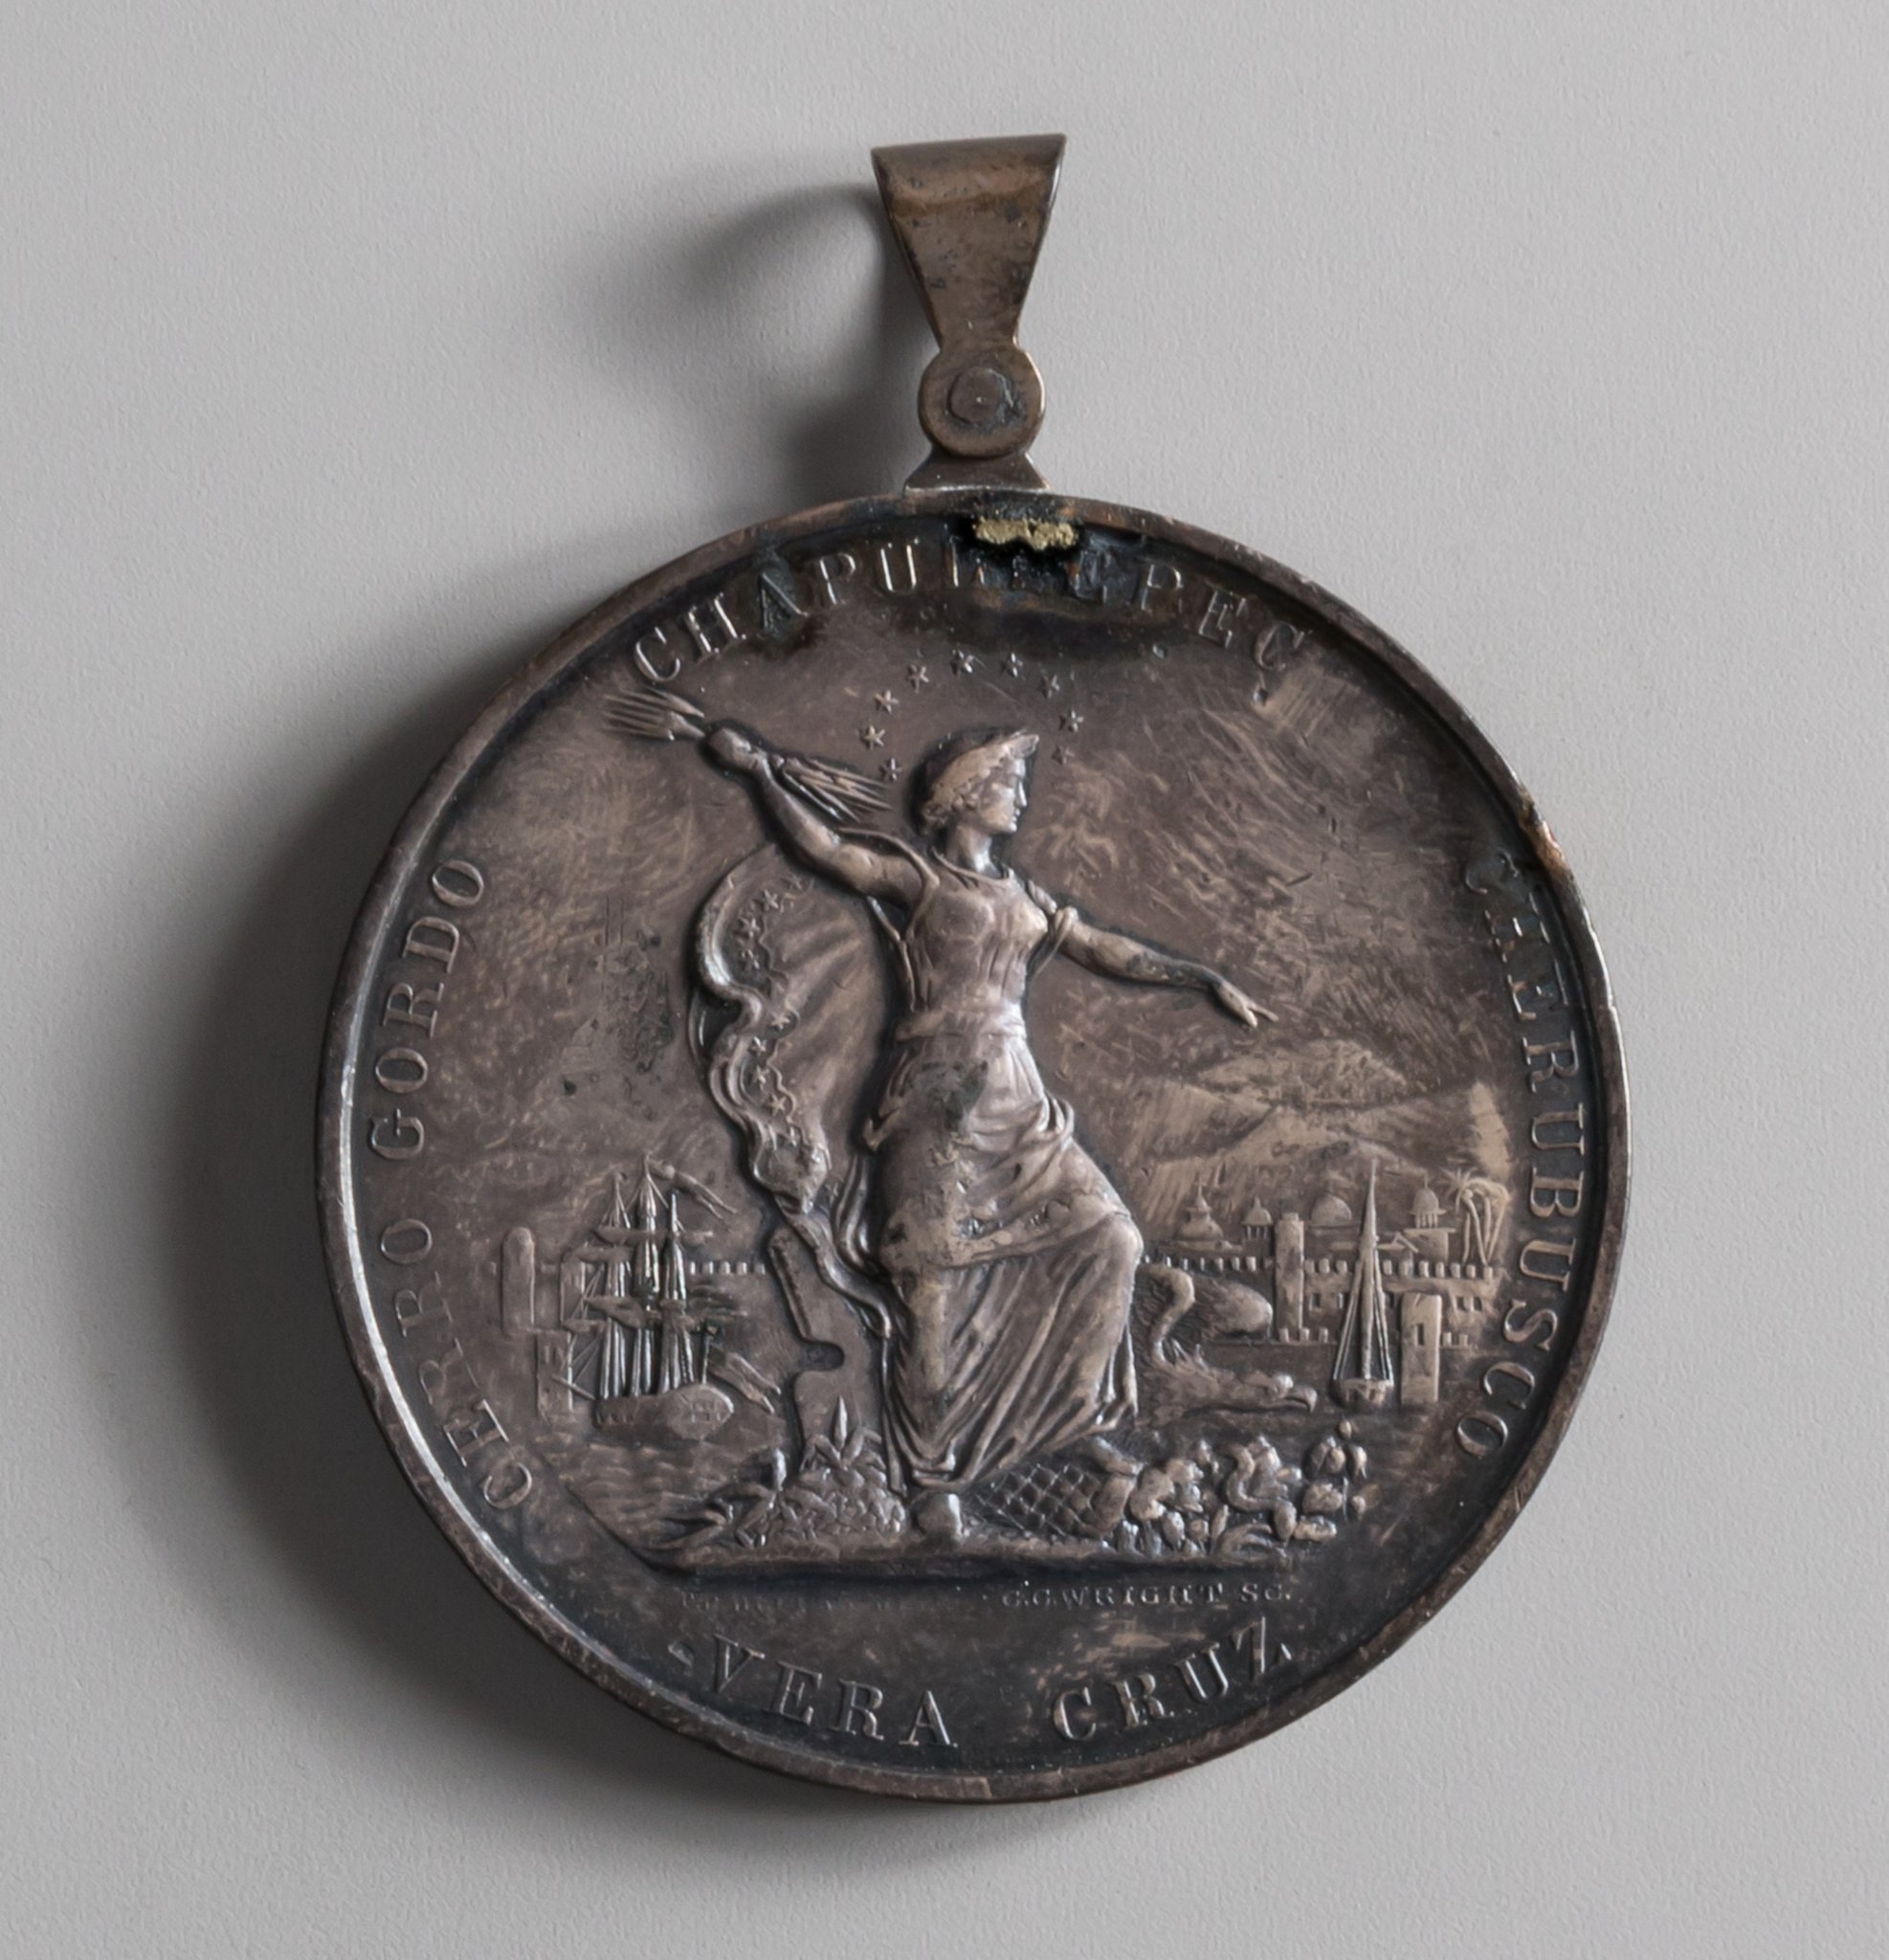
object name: medal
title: Prescribed by the New York City to the Mexican Volunteers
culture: american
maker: charles cushing wright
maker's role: artist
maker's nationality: american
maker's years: 1796-1854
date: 1847-1848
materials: silver